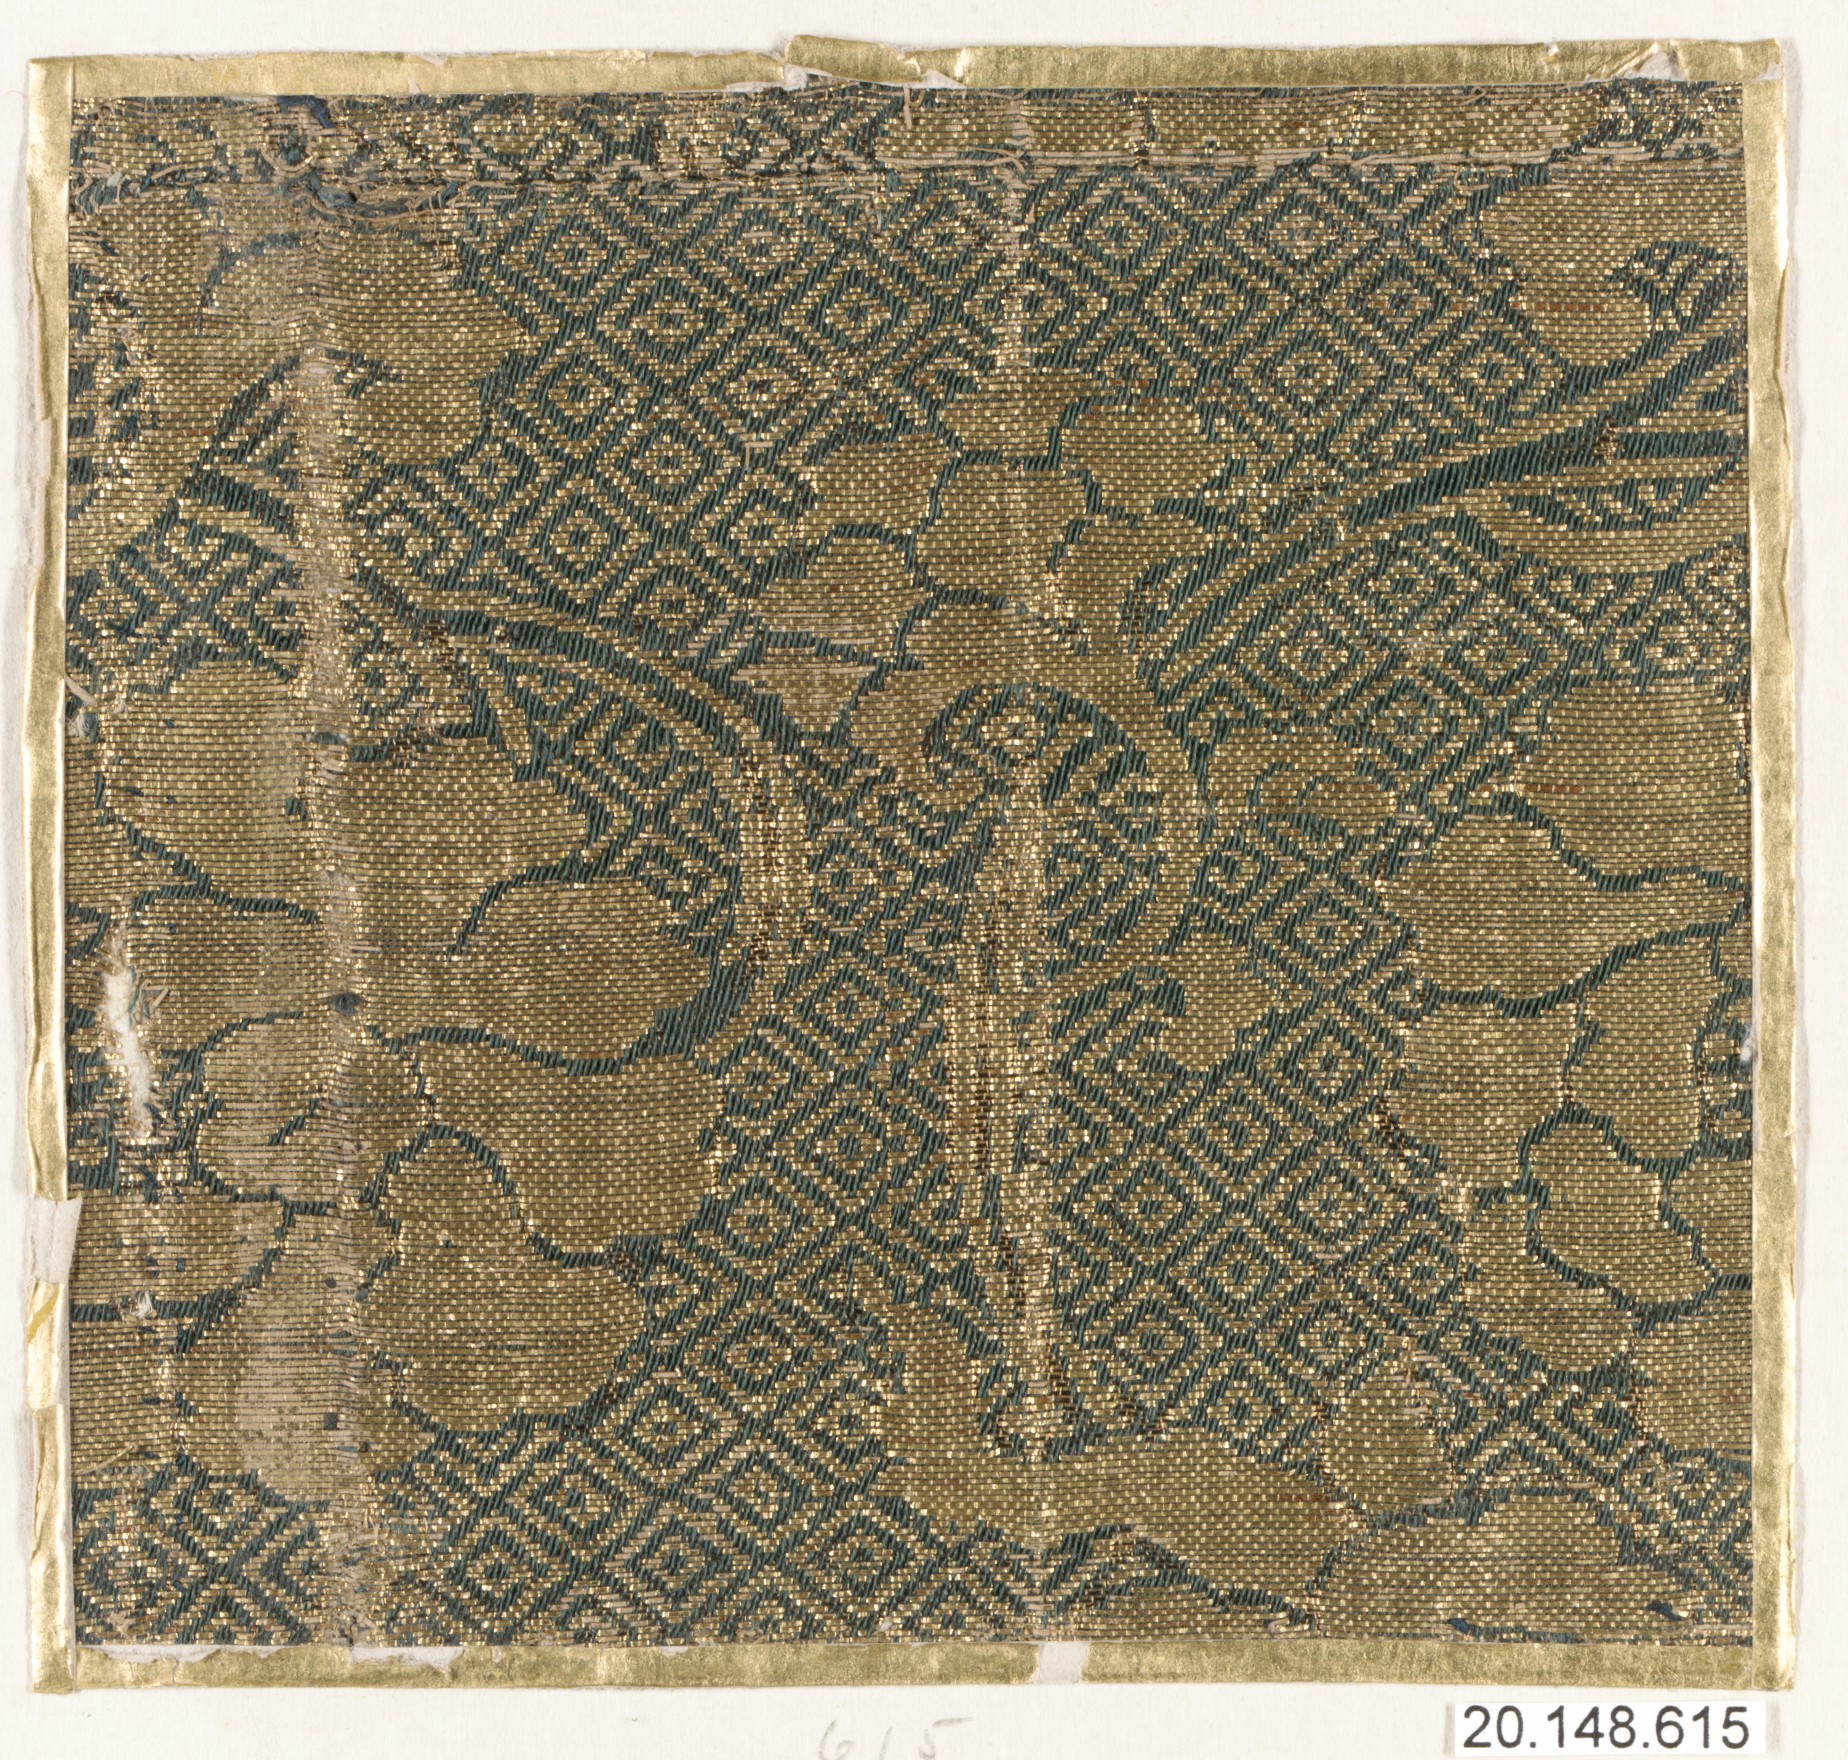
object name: piece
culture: japanese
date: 1601-1700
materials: silk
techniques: compound weave